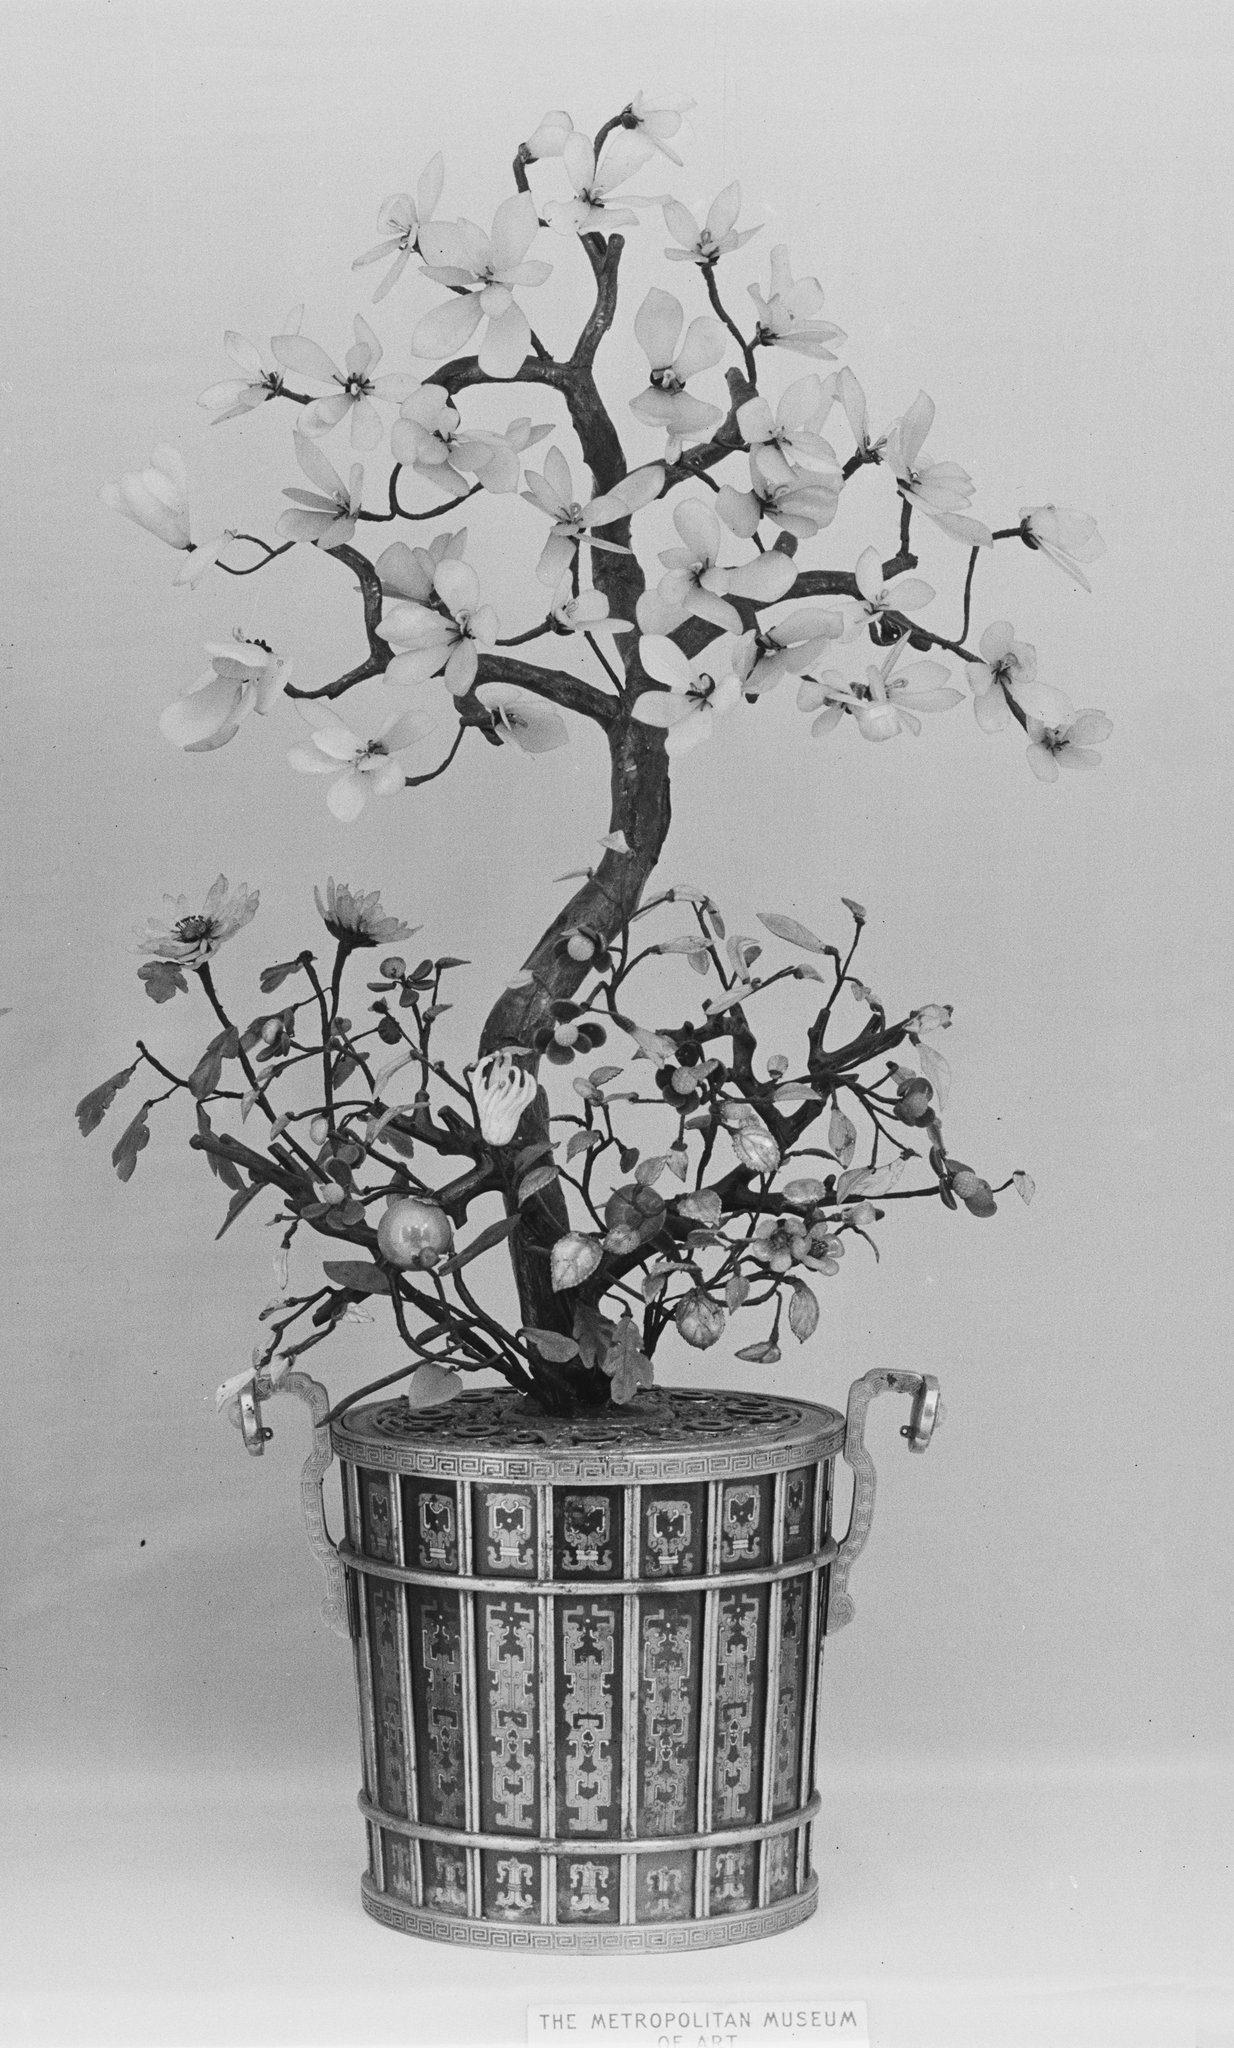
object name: pot with plant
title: Pot with Flowering Plant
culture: chinese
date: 1796-1820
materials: jade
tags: flowers,plants